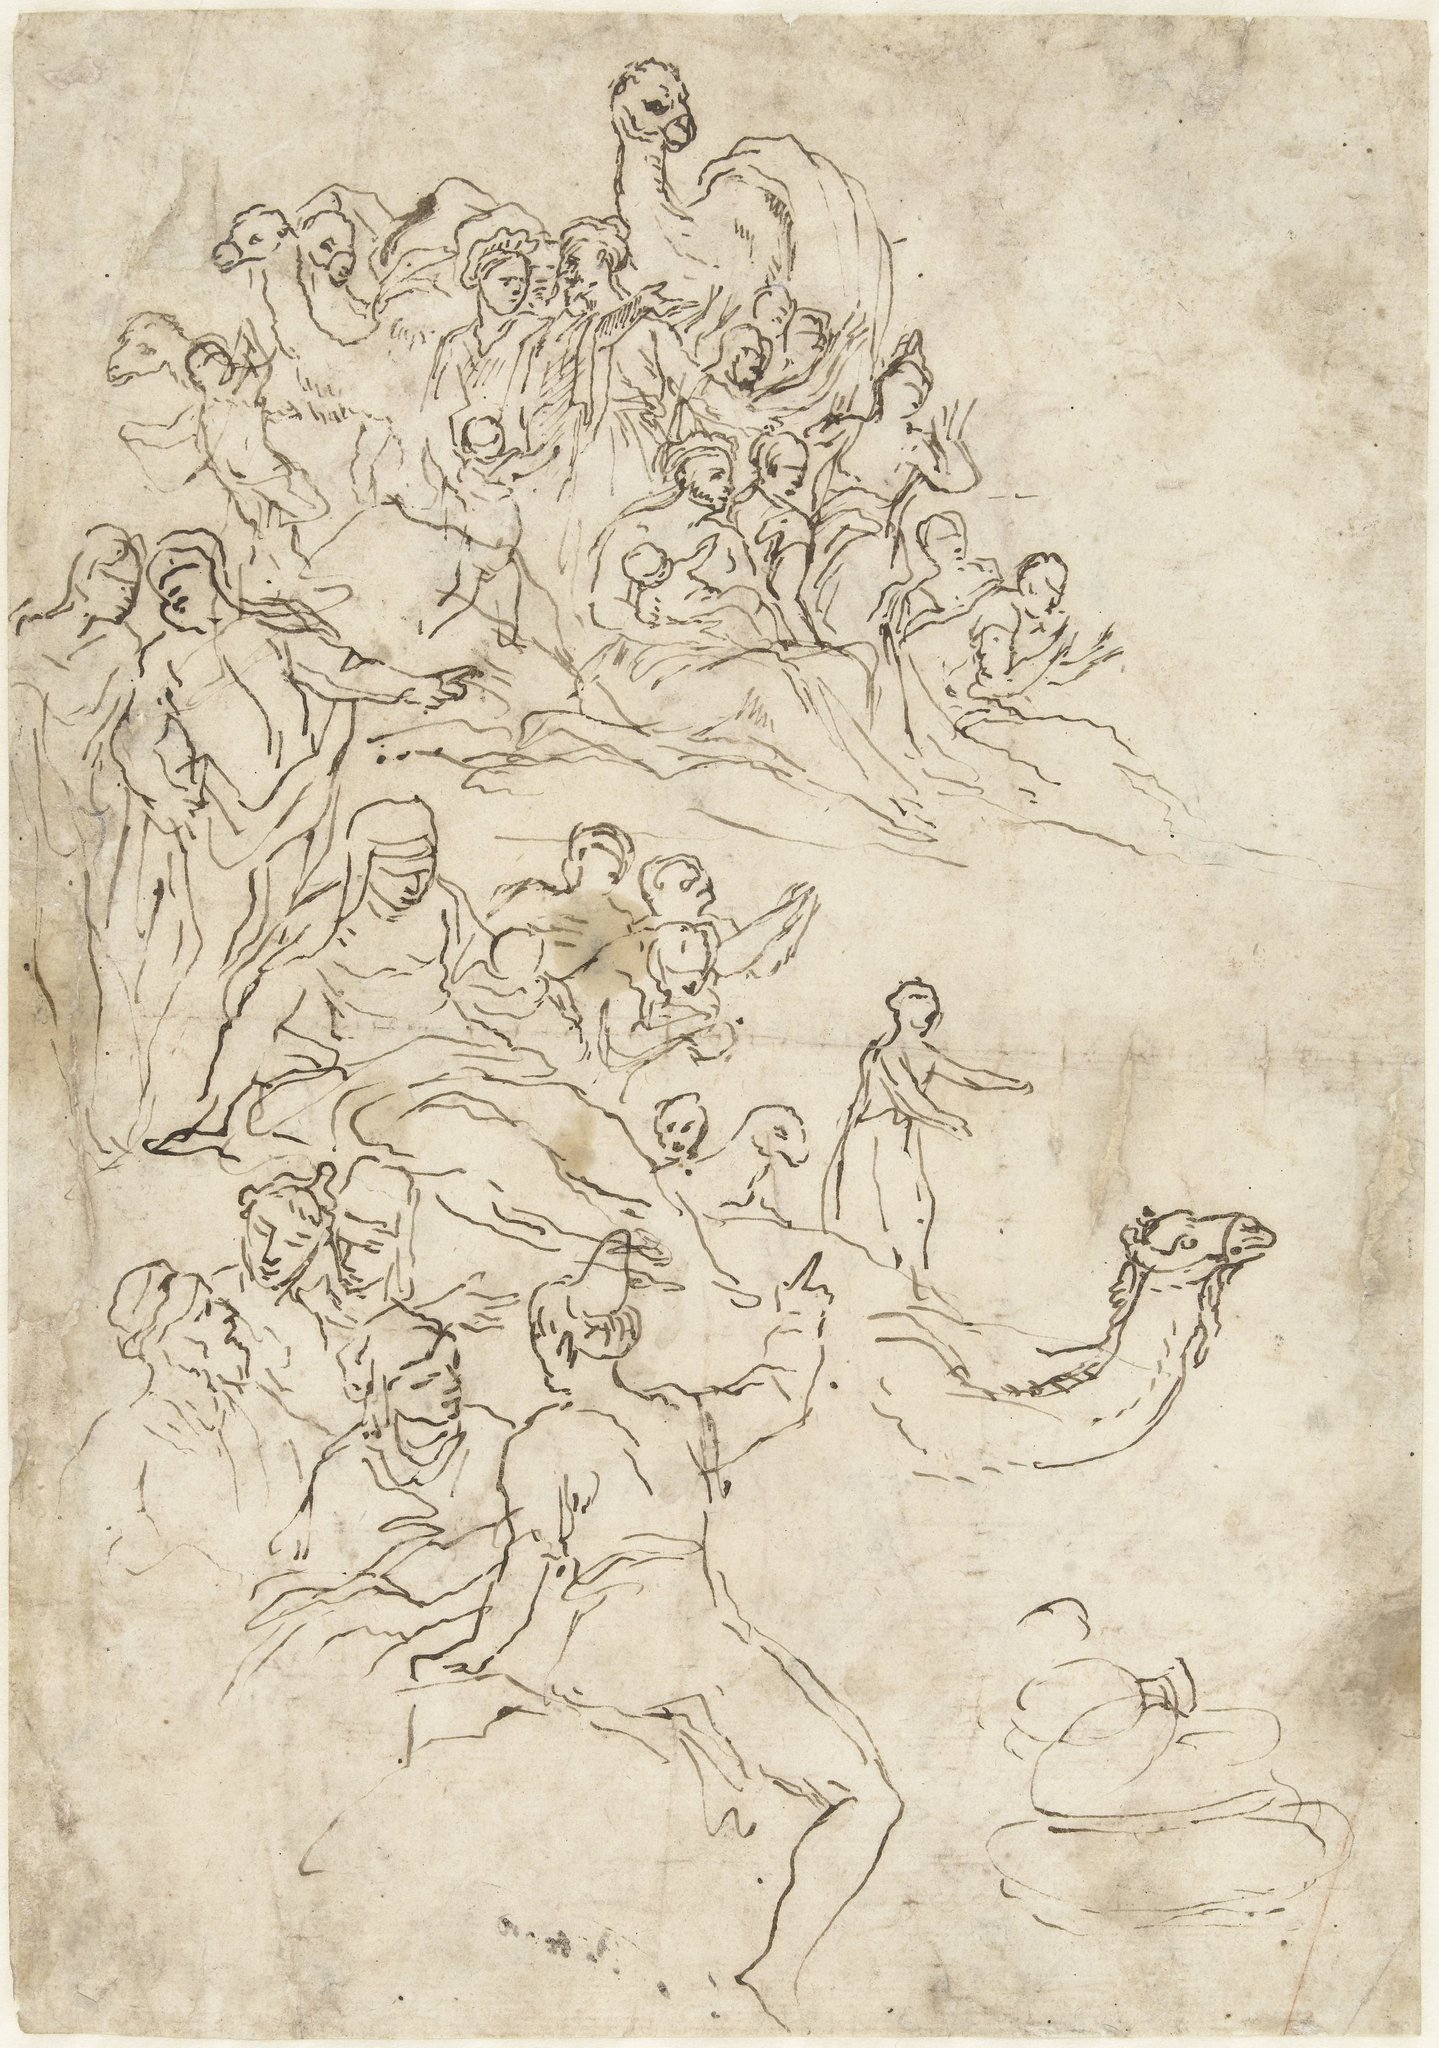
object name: drawing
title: Kamelen en groepen wachtende en gebarende mensen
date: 1550-1620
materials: ink, paper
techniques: pen